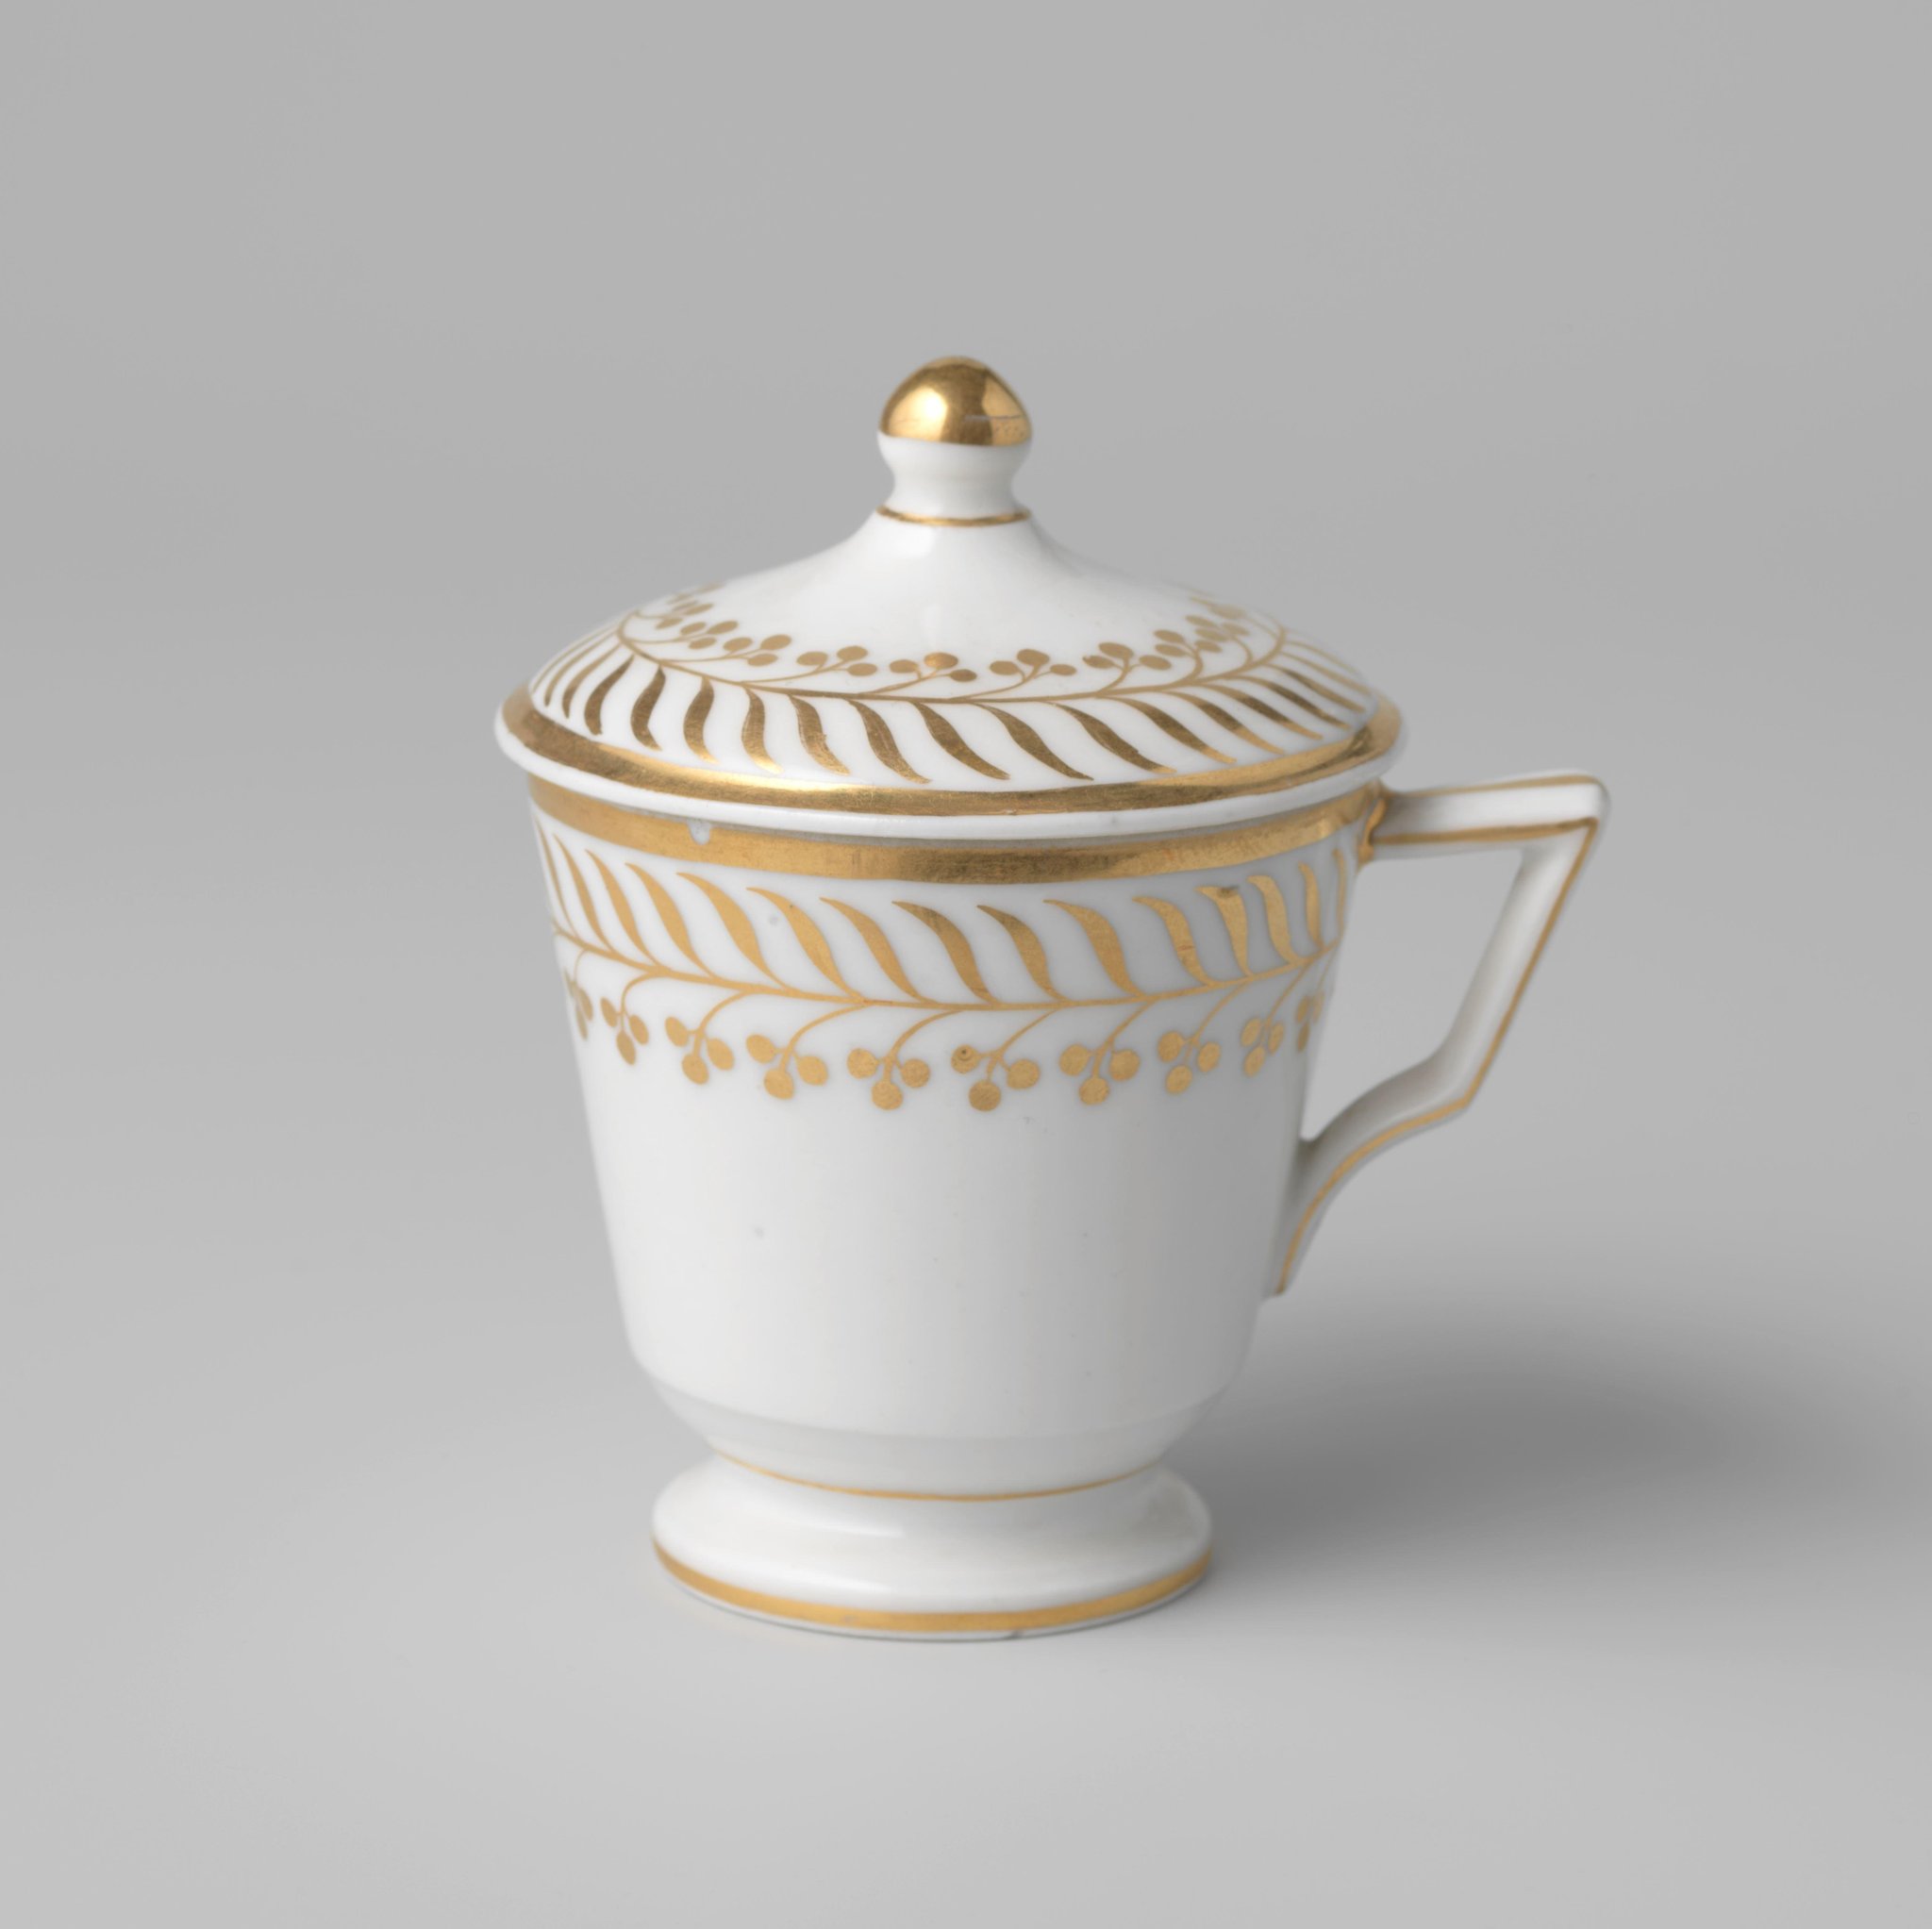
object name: crèmepot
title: Covered cup (pot de crème) with stylized floral scrolls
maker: Anonymous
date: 1800-1810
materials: glaze, gold, paint, porcelain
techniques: firing, forming, gilding, vitrification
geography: france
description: Crêmepot van porselein met oor. Versierd met gouden biezen en langs de randen beschilderd met een doorlopende tak met aan de ene zijde bladeren, aan de andere zijde steeds een tak met drie vruchten. Gemerkt met ingegrifte 1.